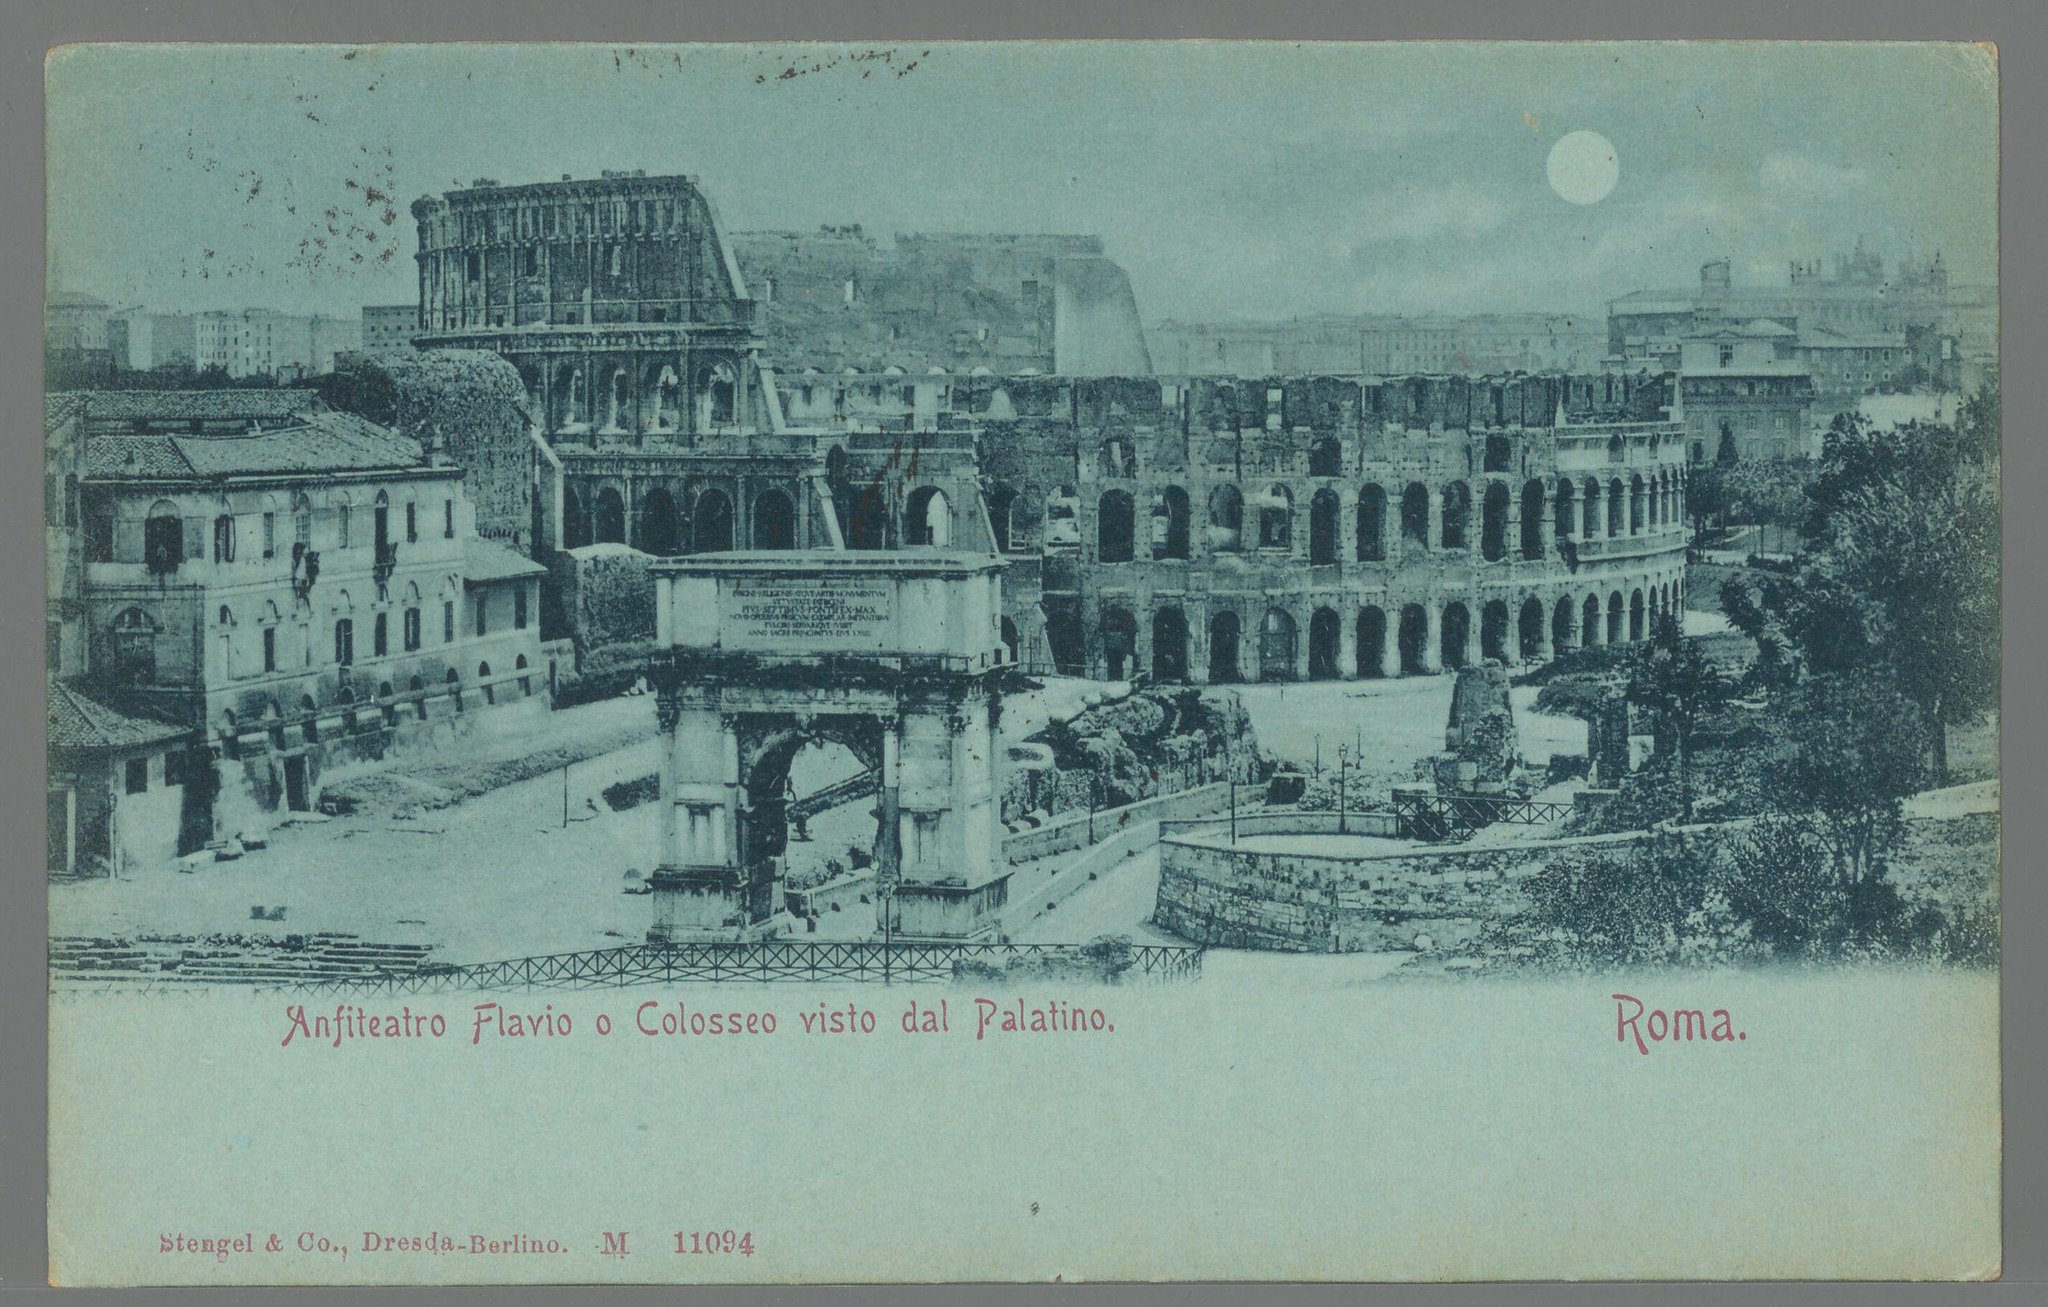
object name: ansichtkaart, prentbriefkaart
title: Anfiteatro Flavio o Colosseo visto dal Palatino. Roma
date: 1899-1902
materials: cardboard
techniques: photograph, writing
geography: dresden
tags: city-view, and landscape with man-made constructions, full moon, amphitheatre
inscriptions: postage stamp